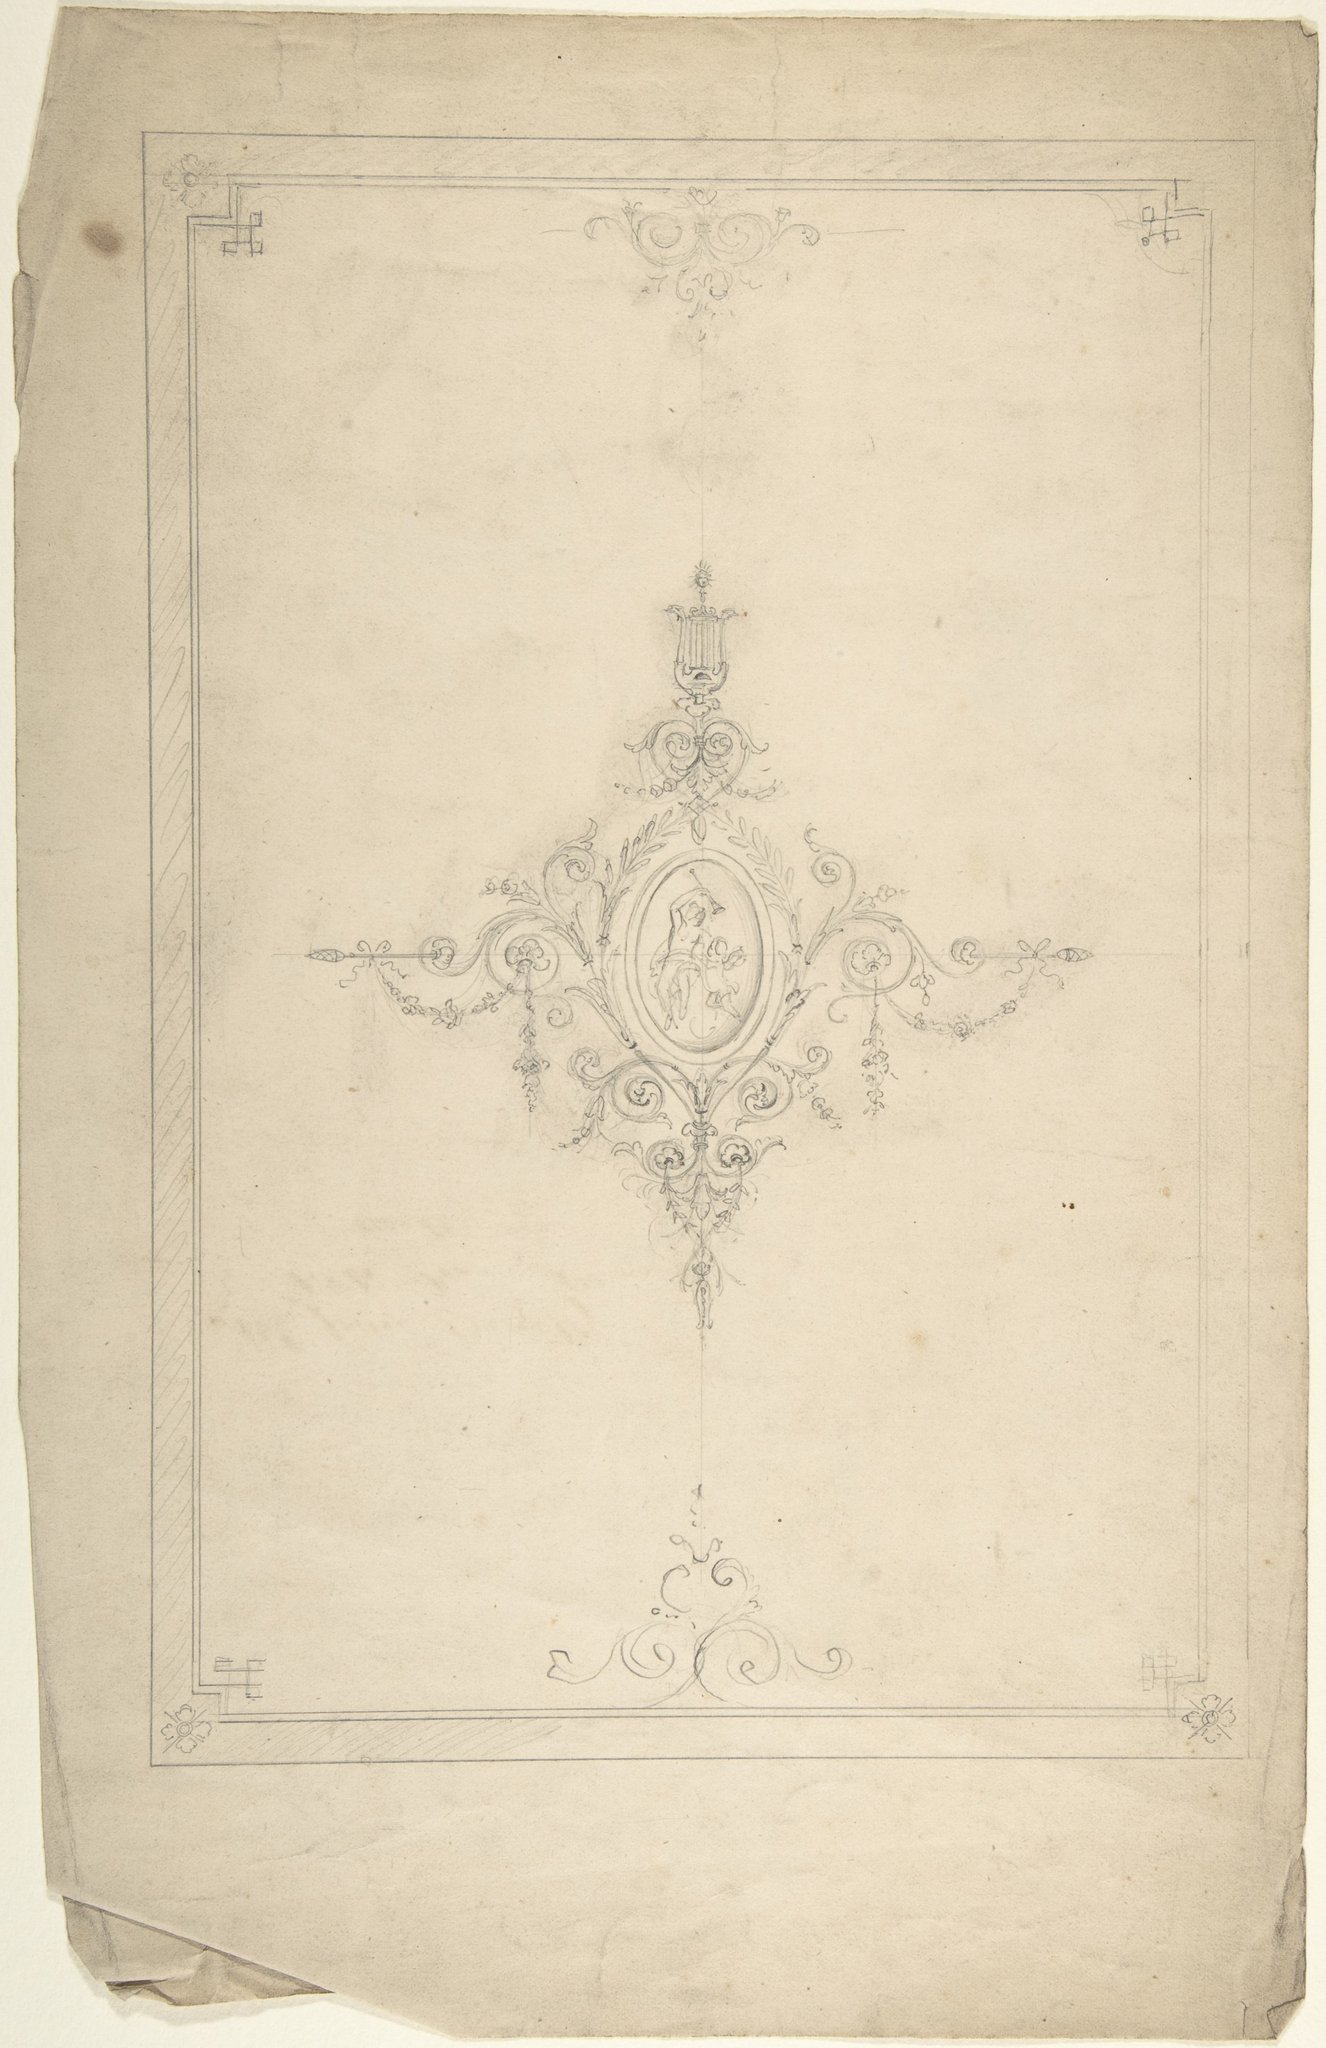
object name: drawing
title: Ceiling Design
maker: anonymous, british, 19th century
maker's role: artist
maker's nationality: british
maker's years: 1800-1900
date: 1801-1900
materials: graphite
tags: ceilings